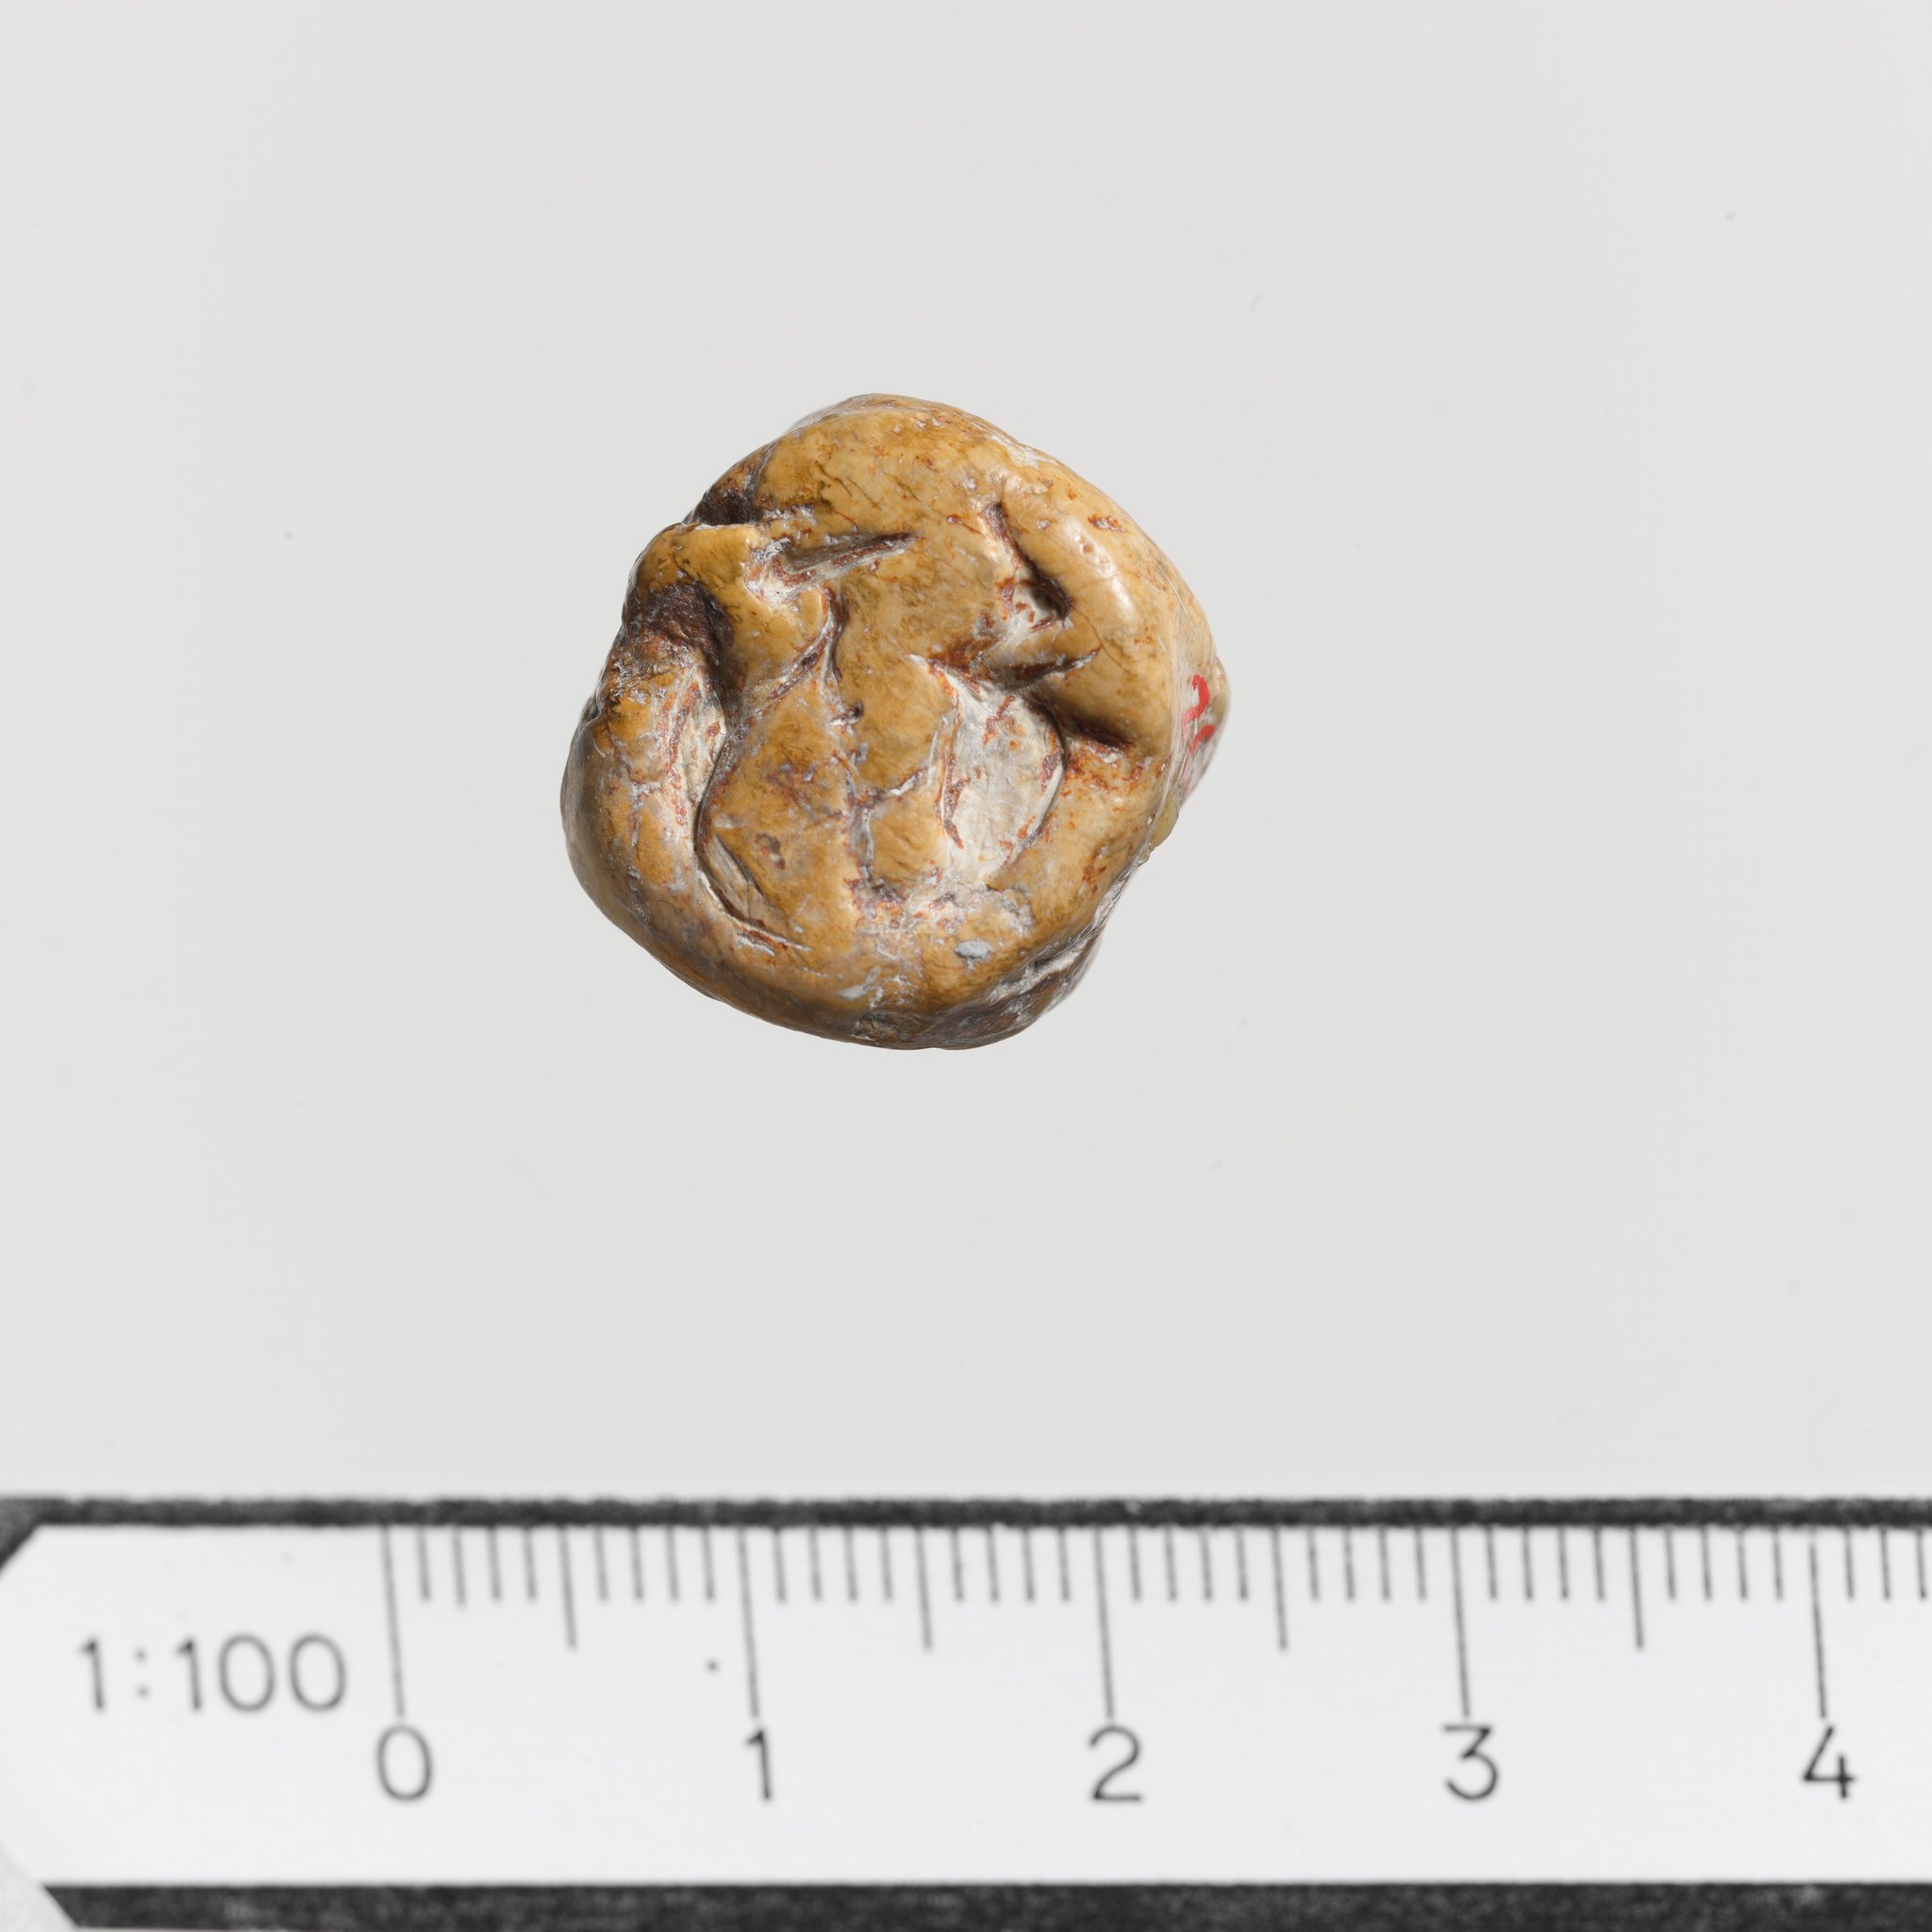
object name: seal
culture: minoan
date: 2600-2000 BCE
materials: stone